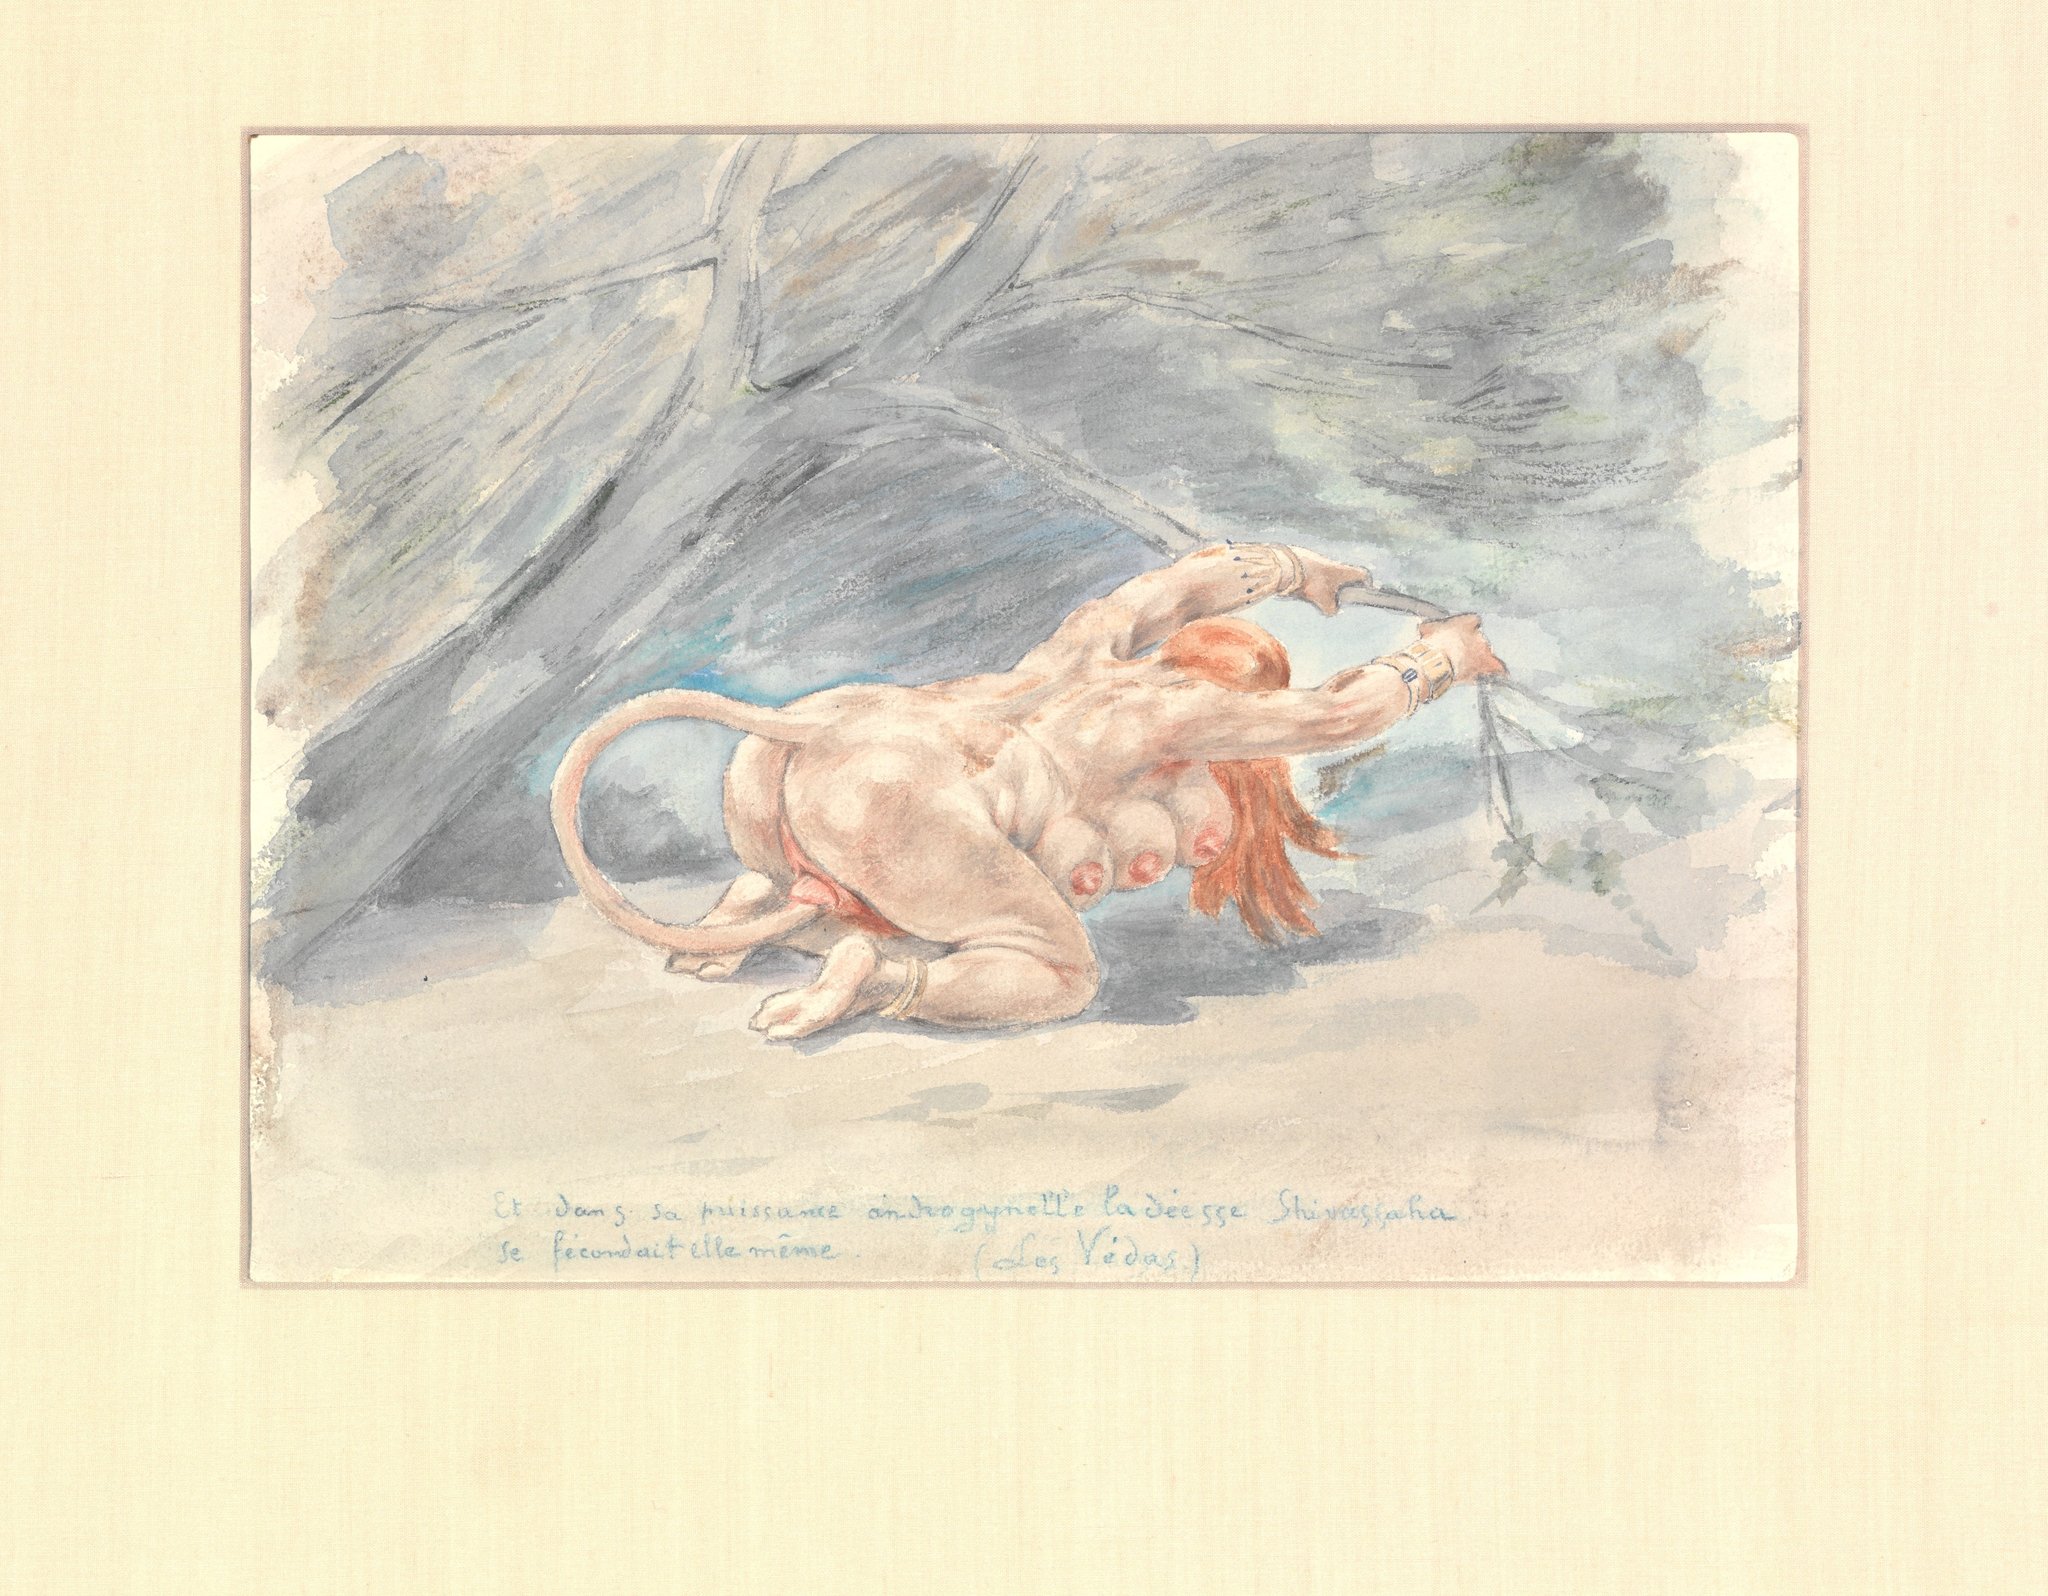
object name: drawing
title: Untitled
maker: félicien rops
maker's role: artist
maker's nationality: belgian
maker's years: 1833-1898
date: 1833-1898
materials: graphite, paper, pencil, watercolor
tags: mythical creatures